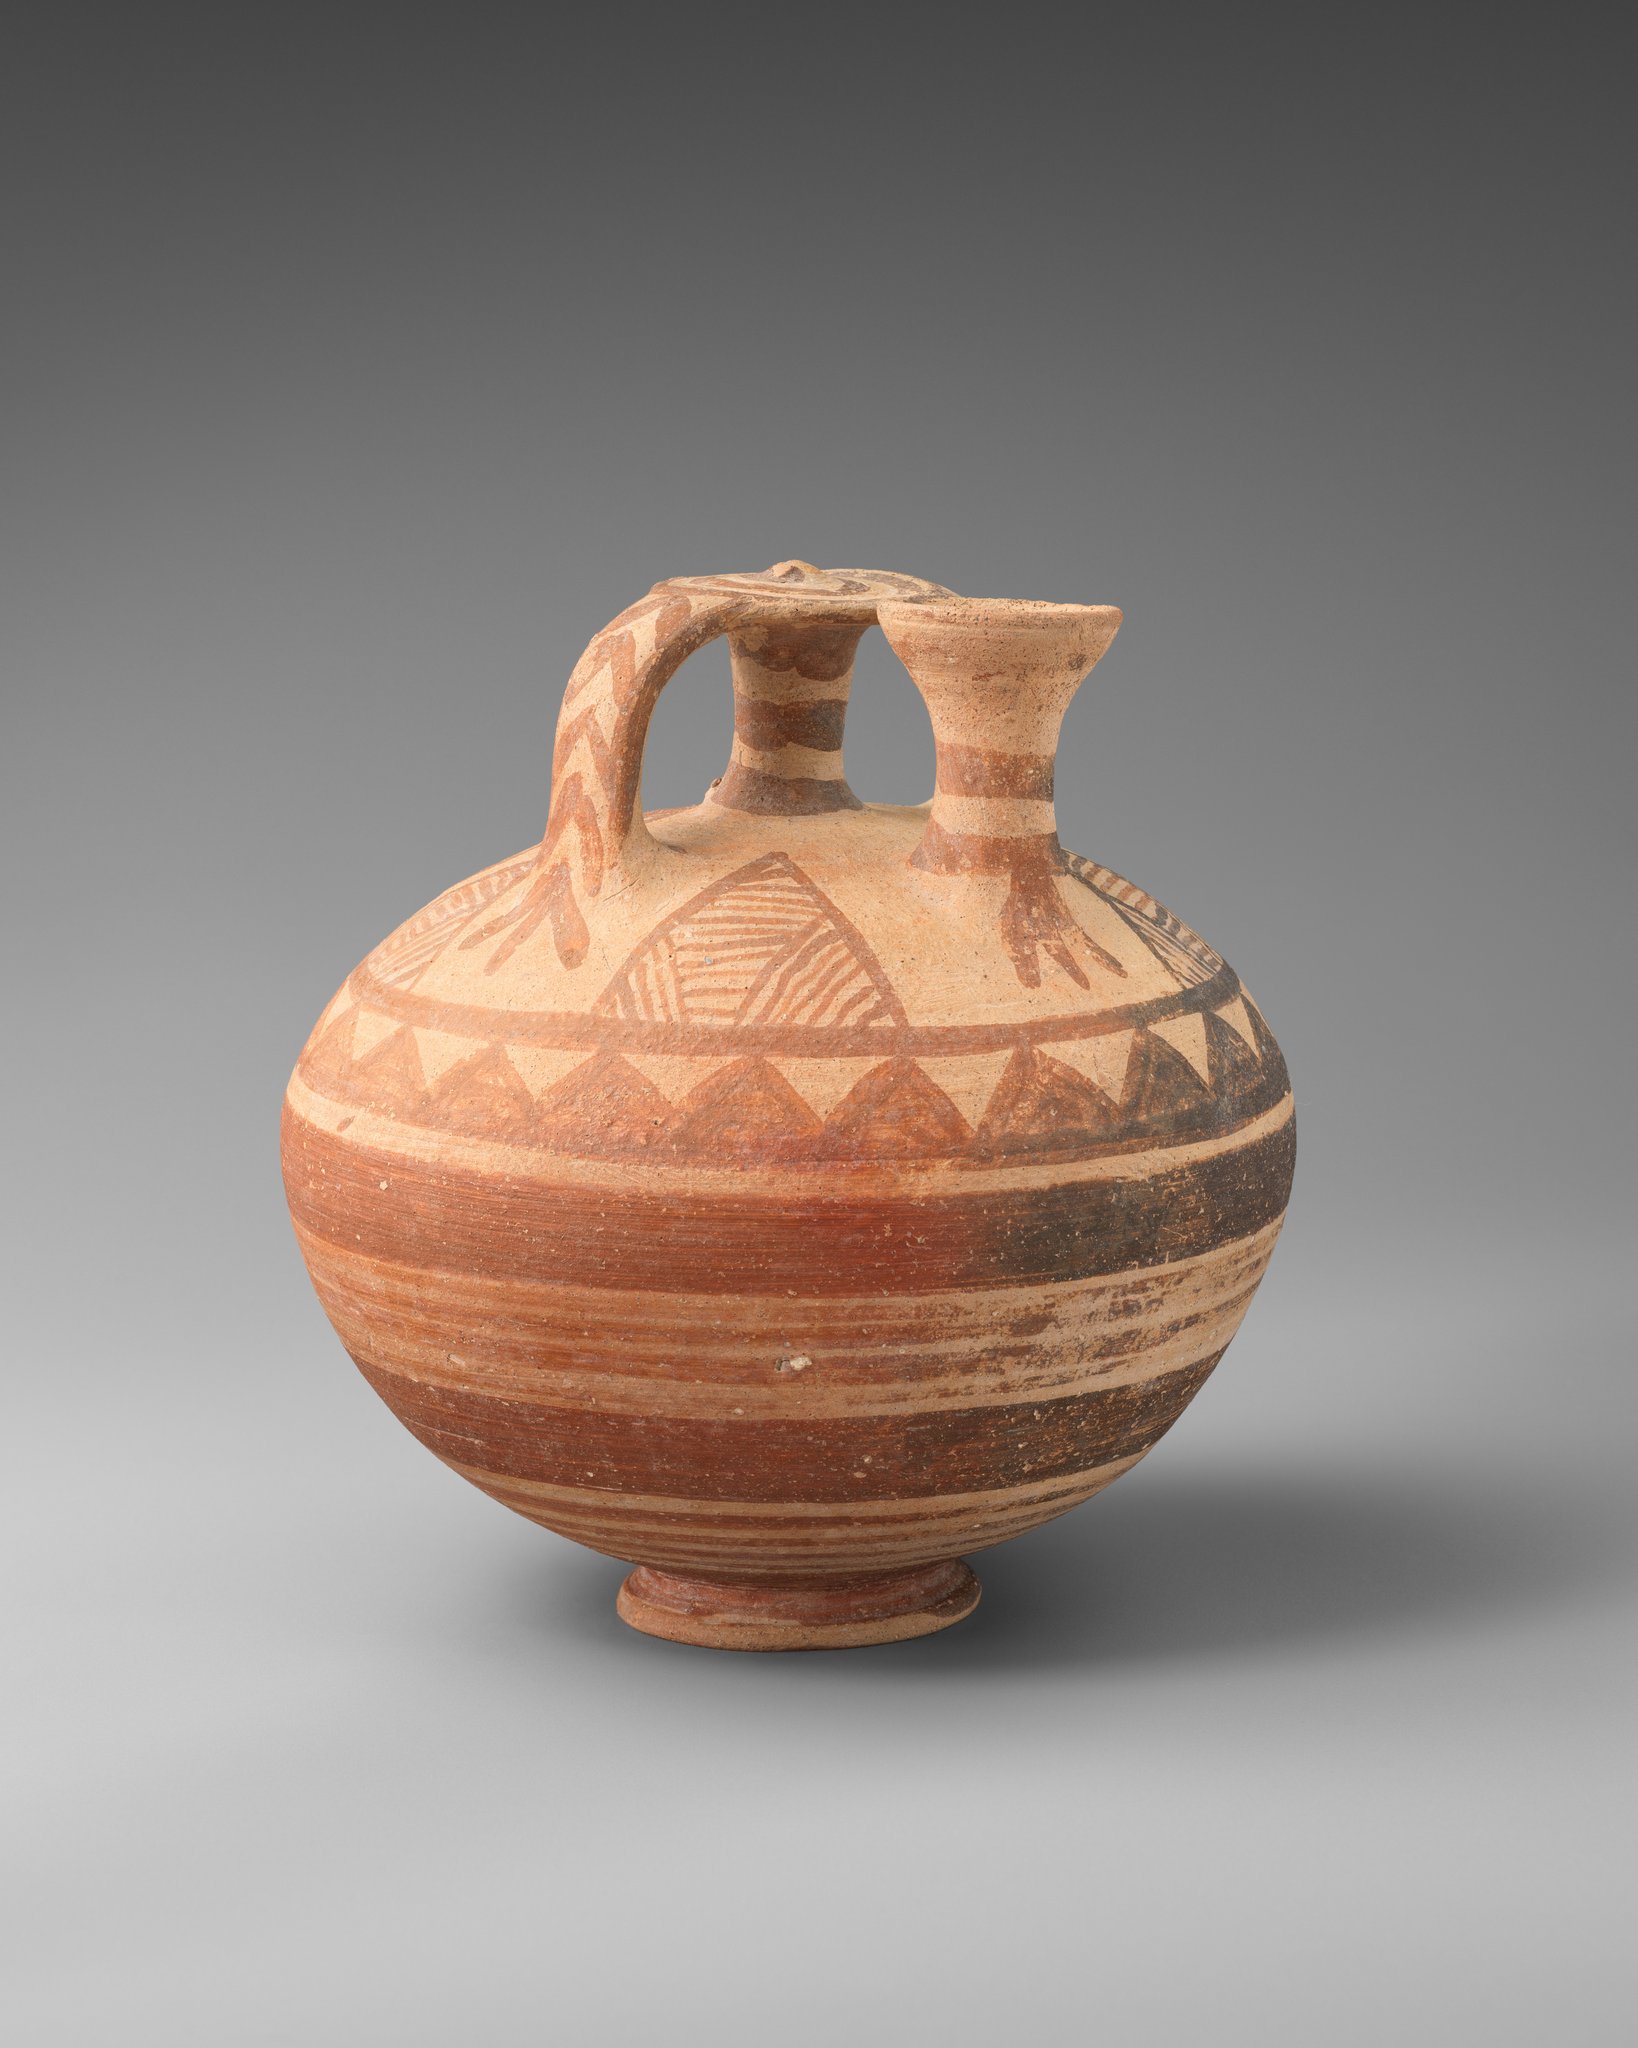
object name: false necked jar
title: Terracotta stirrup jar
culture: cypriot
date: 1200-1050 BCE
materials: terracotta